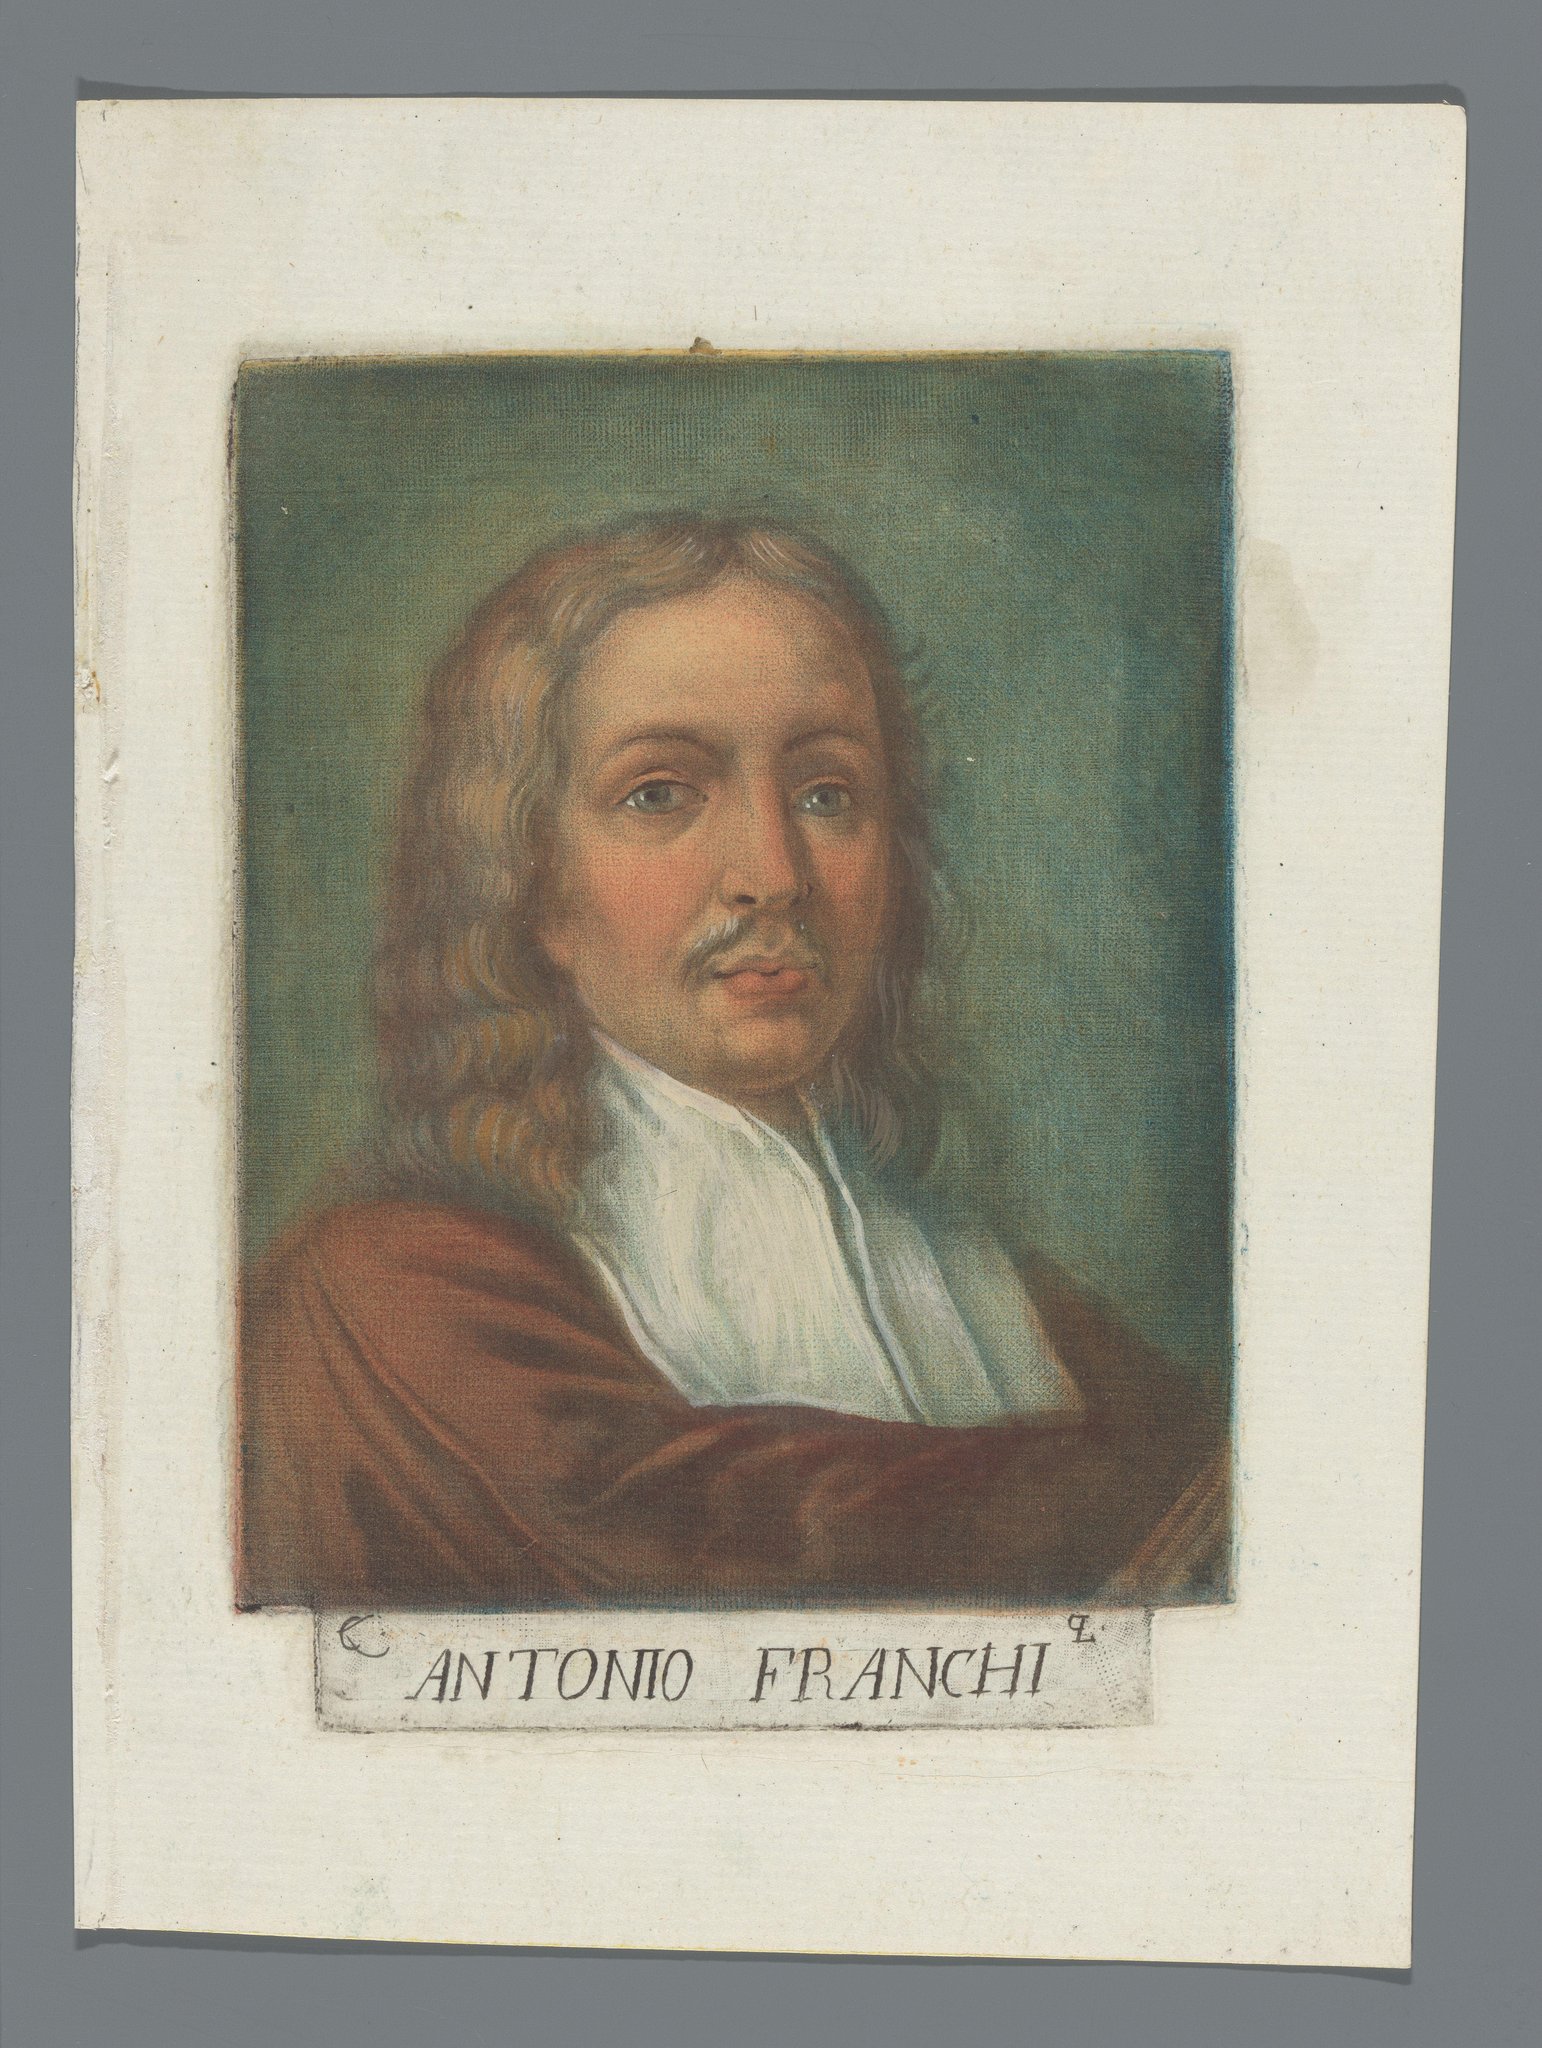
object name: print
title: Portret van Antonio Franchi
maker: carlo lasinio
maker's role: painter, print maker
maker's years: 1759-1838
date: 1789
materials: gouache, paper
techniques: color mezzotint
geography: florence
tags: antonio franchi, historical persons, portrait, self-portrait of painter, portrait, self-portrait of artist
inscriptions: collector's mark: Lugt 2228, number: ‘57’, inscription:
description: Een prent uit een groep van veertig kleurendrukken met kunstenaarsportretten, gebaseerd op de collectie geschilderde zelfportretten van kunstenaars verzameld door de Medici in Florence. De groep maakt deel uit van het grote werk van Lasinio ‘Gli Autoritratti della Real Galleria di Firenze’, uitgegeven in 1789 met omstreeks 350 kunstenaarsportretten. Van deze uitgave is tot nog toe is geen compleet exemplaar bekend. In de inspringende marges onderaan de prenten zijn de namen van de kunstenaars aangebracht en soms hun levensdata en de plaats van geboorte en sterven en een enkele maal de signatuur van Lasinio en dat van de drukker Labrelis. Getuige de bindgaatjes en lijmresten moeten de prenten ingebonden zijn geweest in een album. De meeste prenten zijn verso voorzien van nummers in potlood, met als laagste nummer 2 en hoogste 93. Tevens zijn er verso Italiaanse opschriften in pen aangebracht met de levensdata van de kunstenaars en de school waartoe zij worden gerekend. Deze opschriften zijn vrijwel alle deels afgesneden. Elf prenten zijn niet genummerd en niet voorzien van opschriften. Deze laatste elf zijn alle gedrukt op blauw papier.